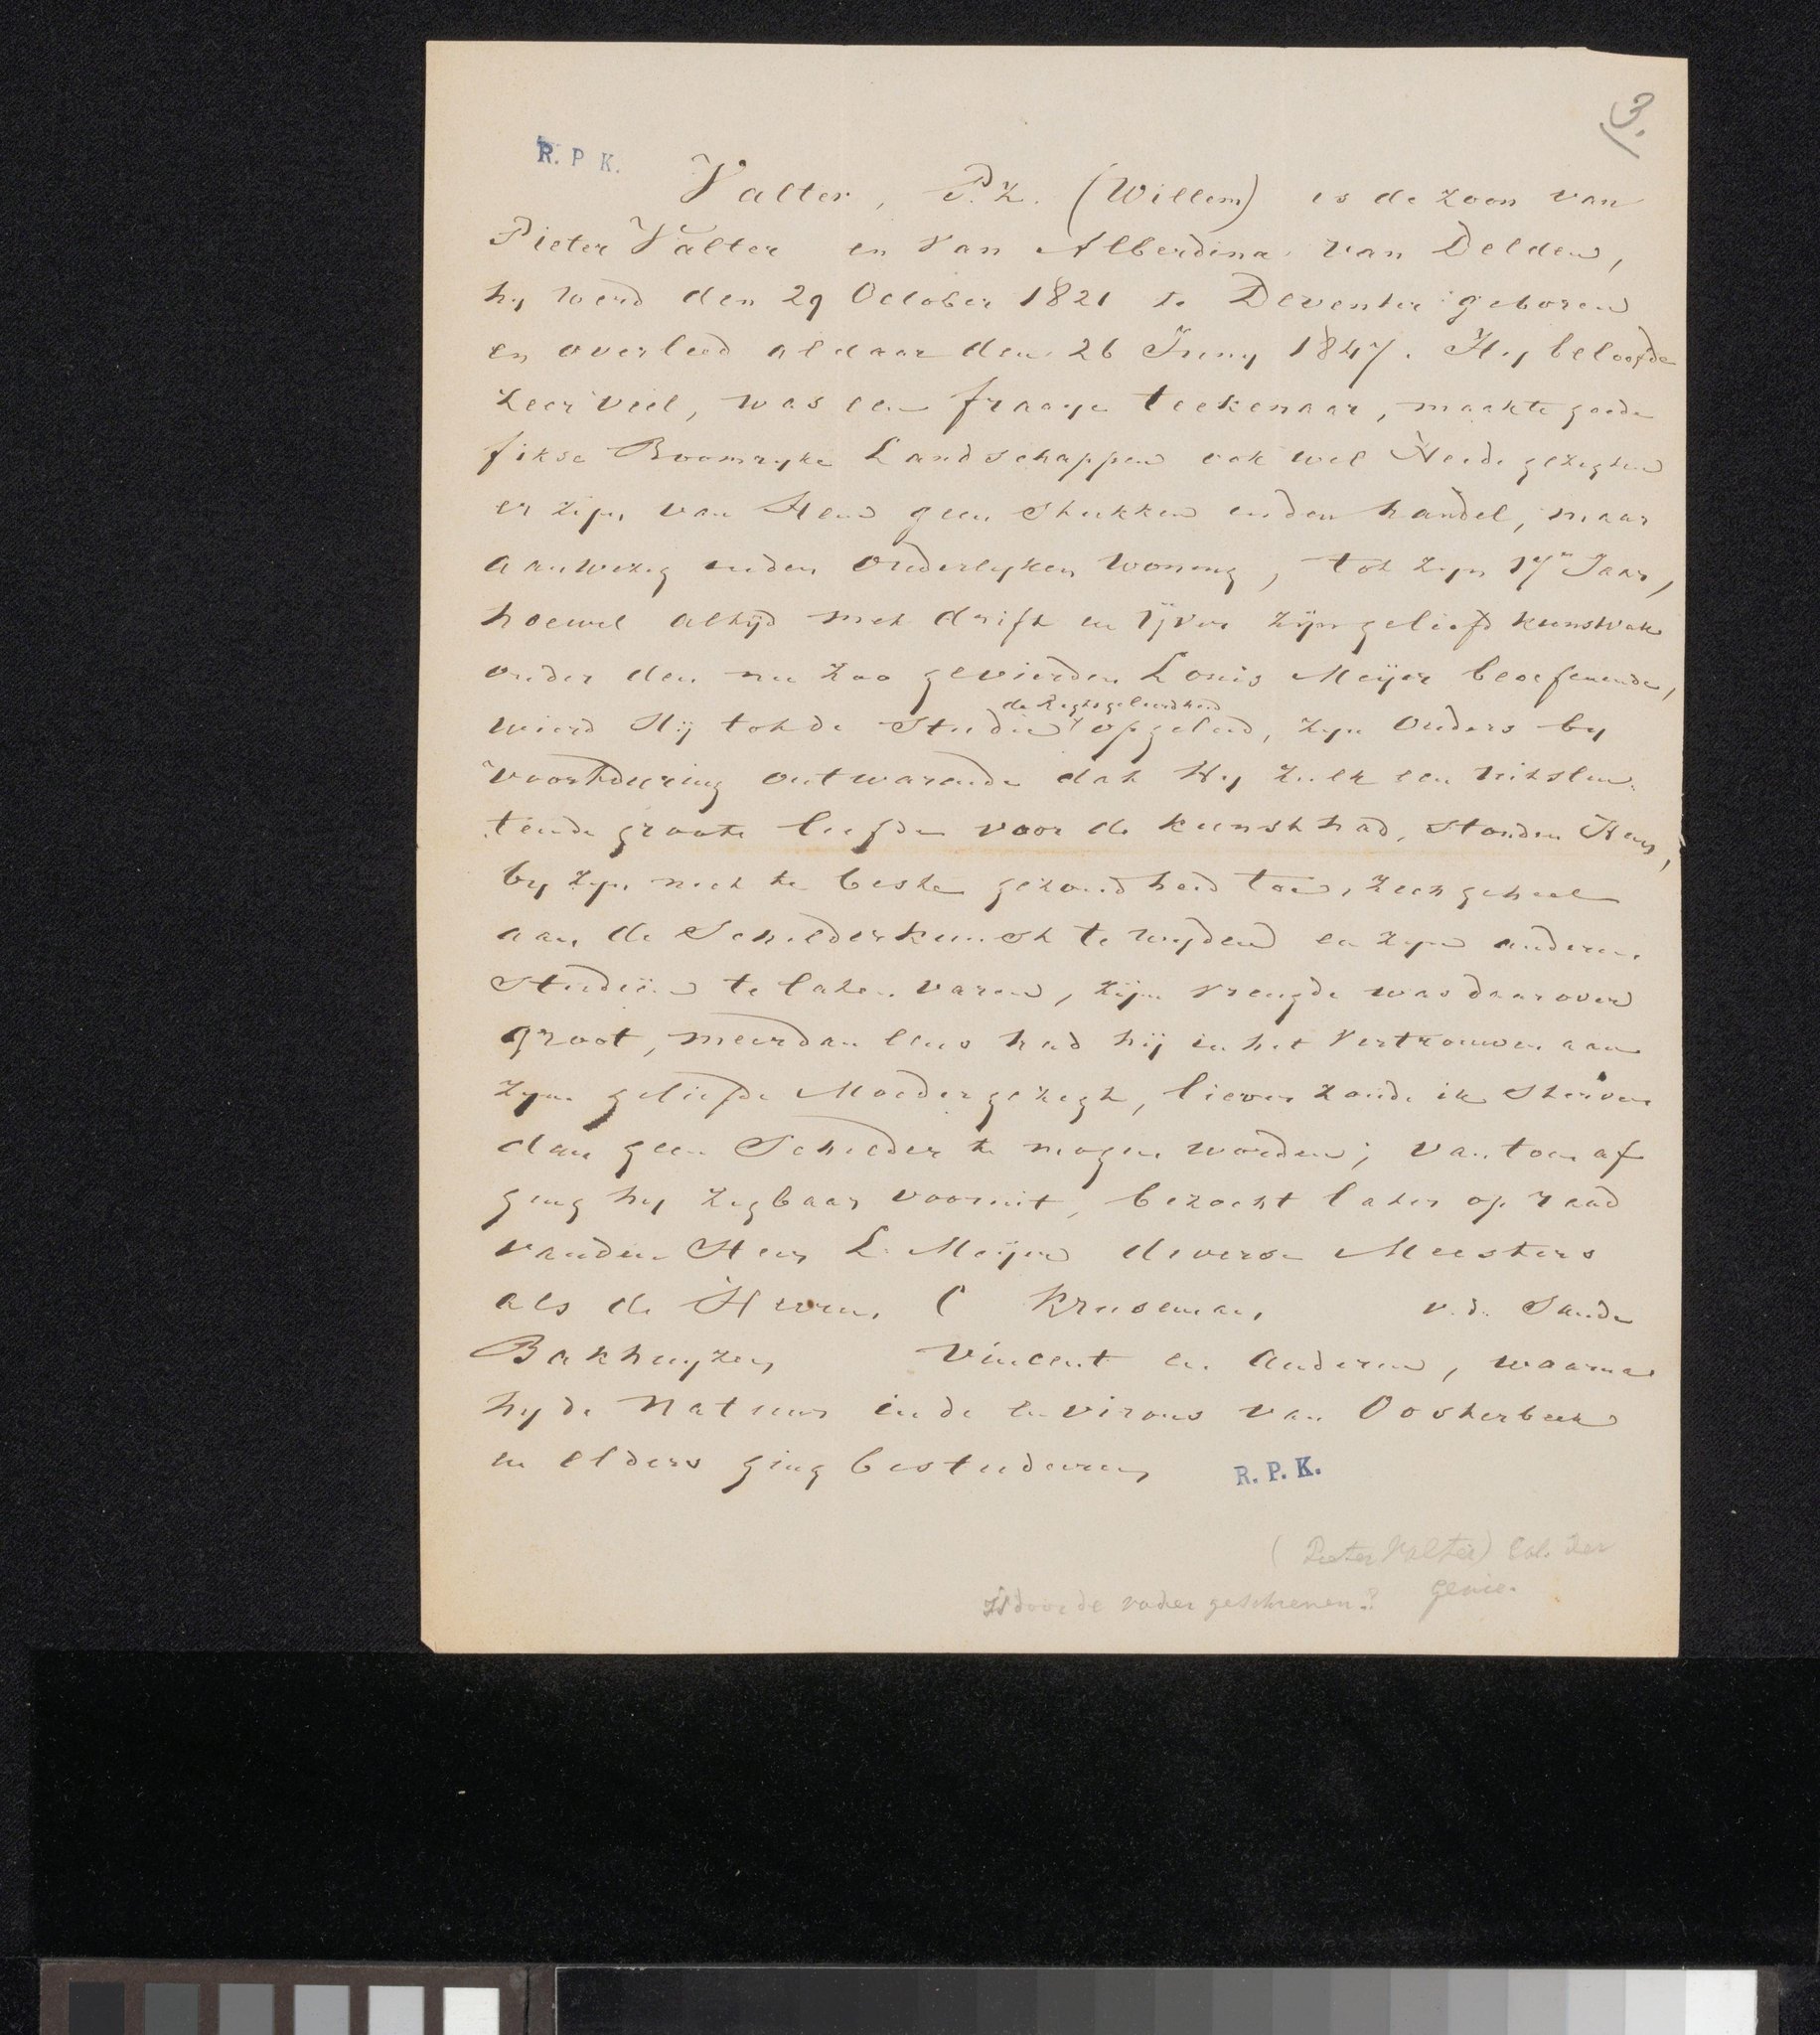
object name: manuscript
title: Handschrift betreffende Willem Valter Pzn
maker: Anonymous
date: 1847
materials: ink, paper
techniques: pen, writing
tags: amsterdam, utrecht, painter, print maker, draughtsman, louis meijer, cornelis kruseman, hendrikus van de sande bakhuyzen, the hague, lodewijk anthony vintcent, deventer, willem valter pzn, drawing, education, tuition of the artist (in general), painting (including book-illumination, miniature-painting)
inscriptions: collector's mark: Lugt 2233